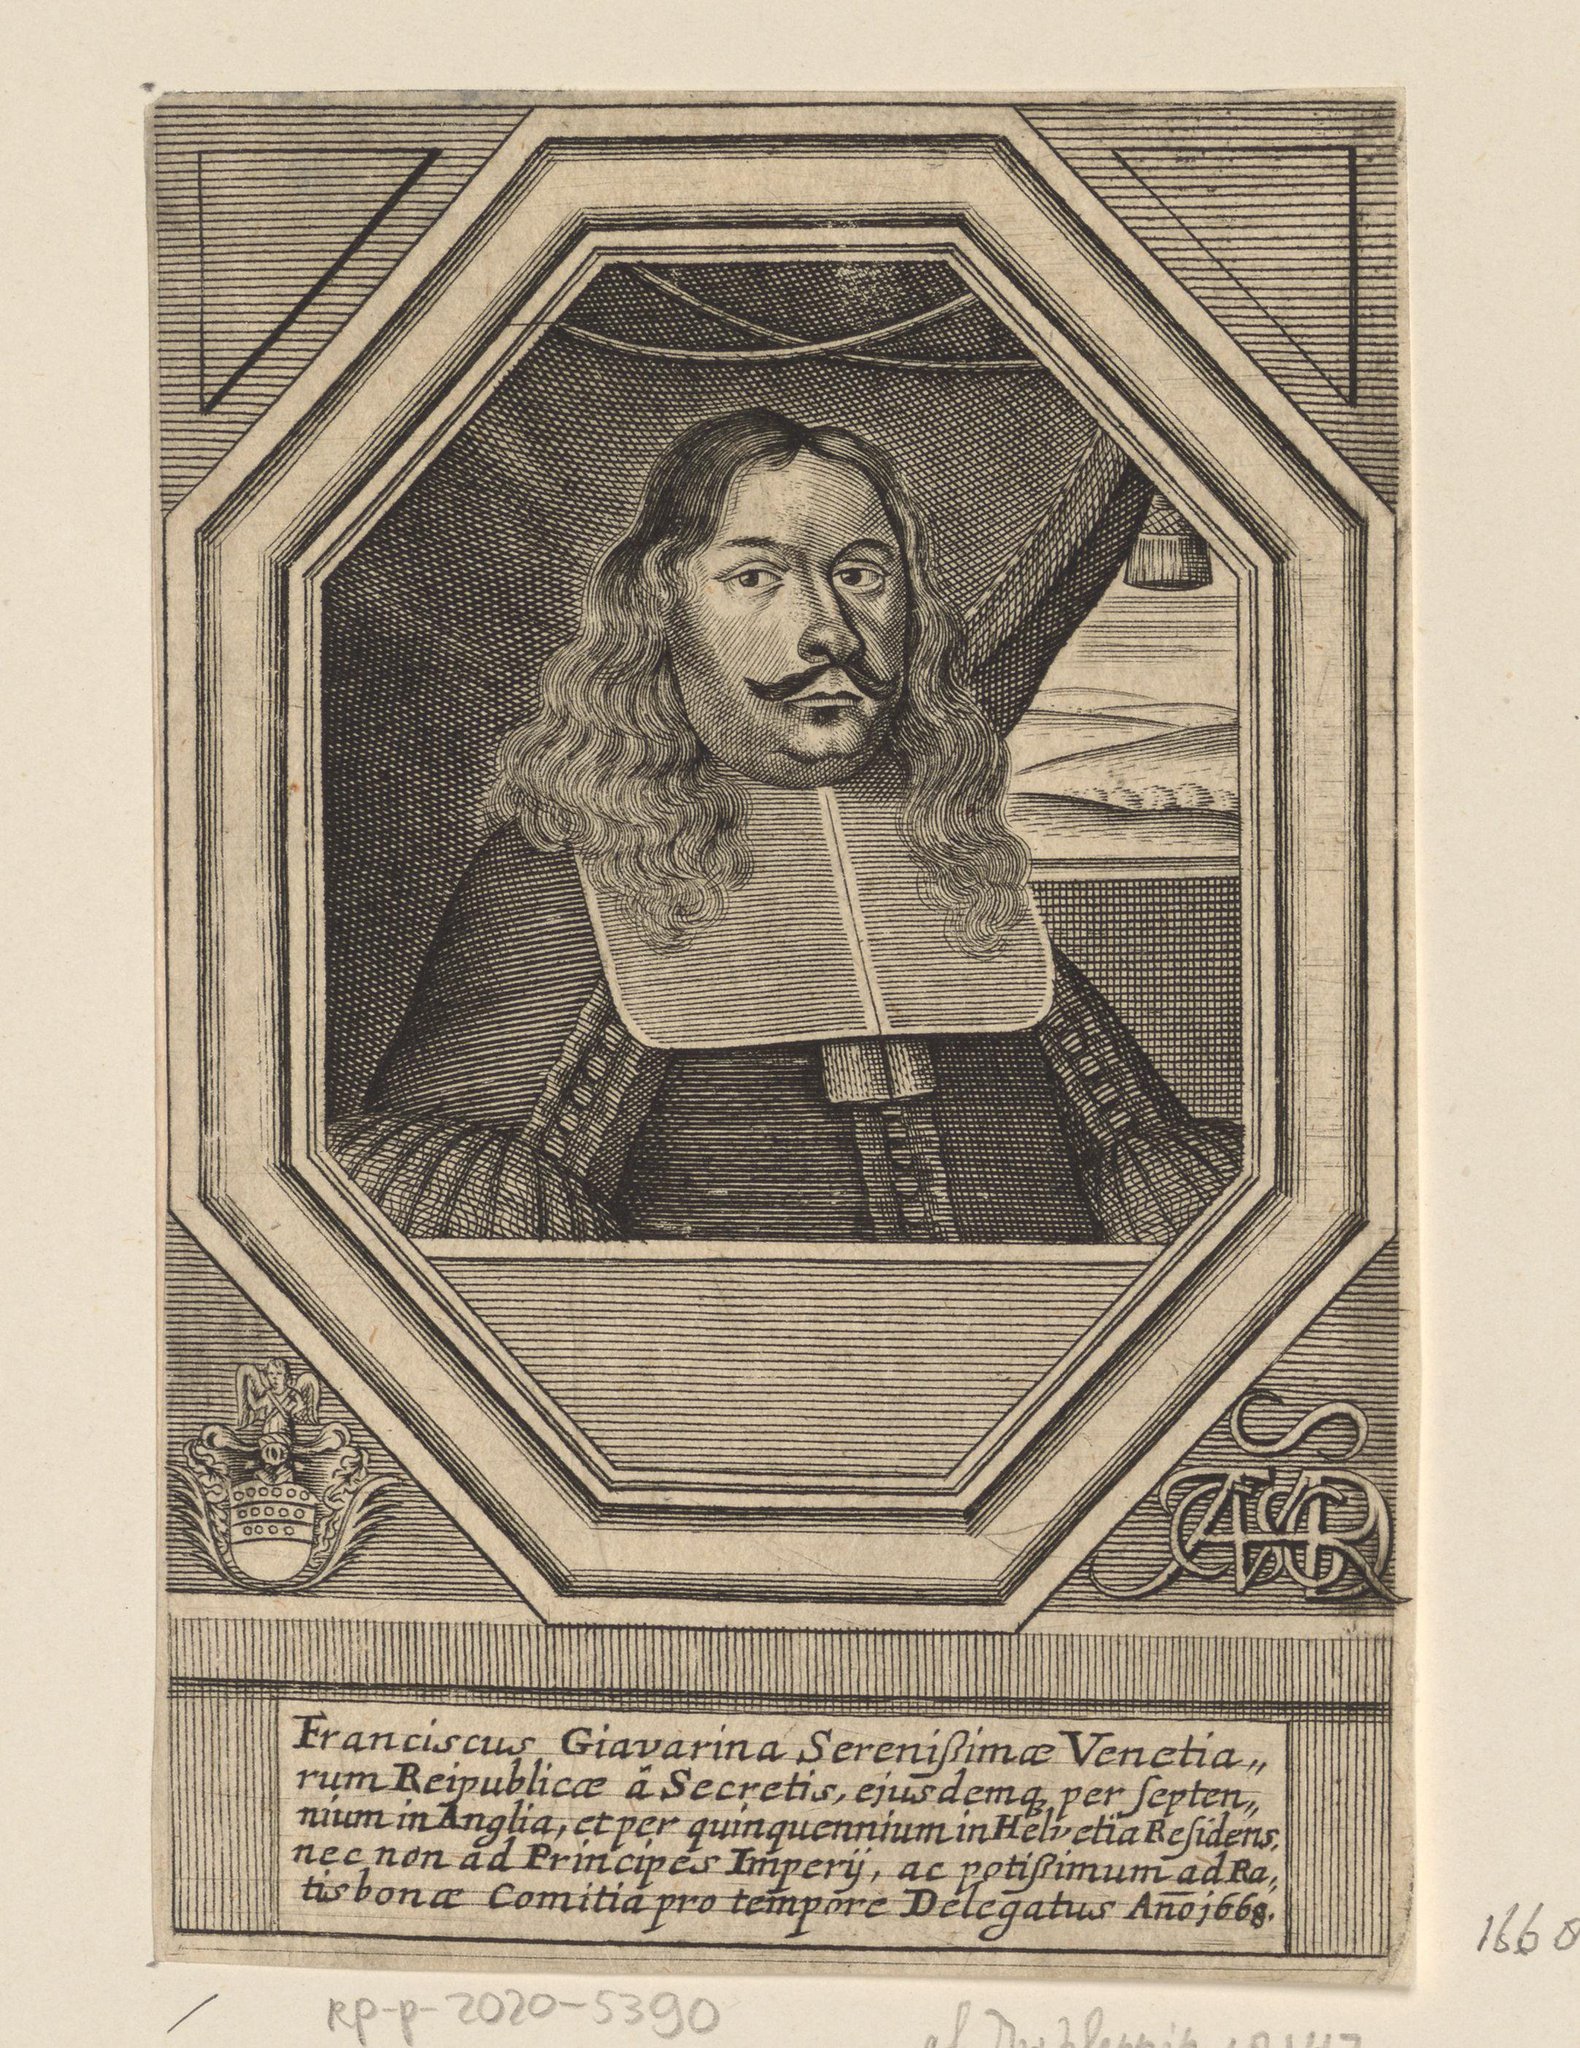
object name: print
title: Portret van Giavarina Gerolamo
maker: Anonymous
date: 1668-1780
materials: paper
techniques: engraving, etching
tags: historical persons, diplomacy, diplomat